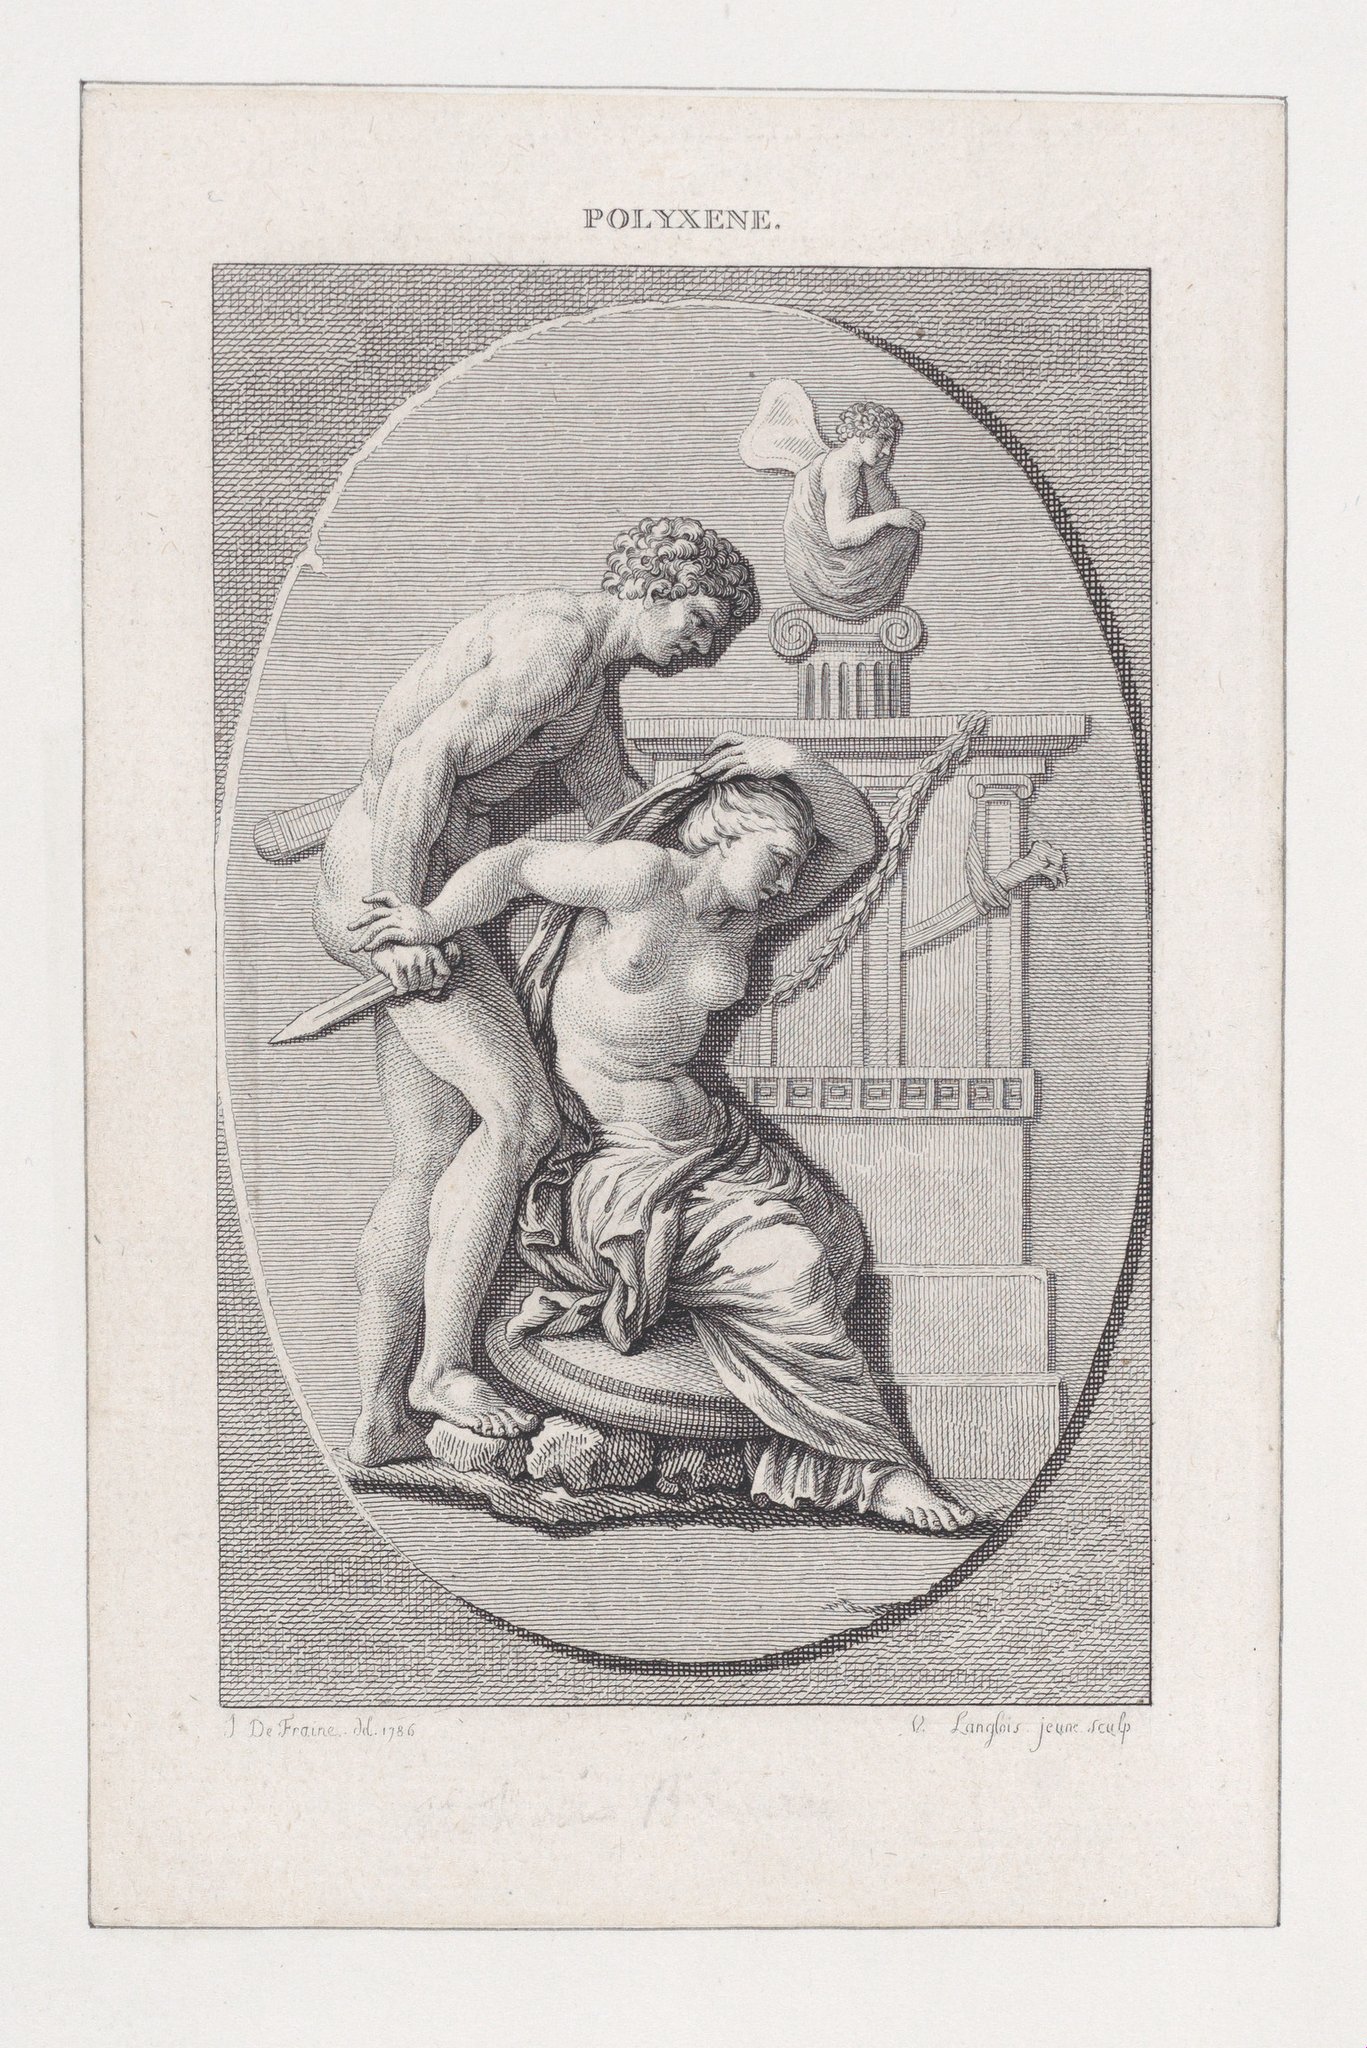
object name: print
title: Polyxena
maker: vincent marie langlois, le jeune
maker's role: artist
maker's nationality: french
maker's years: 1756-1856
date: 1786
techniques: engraving, etching